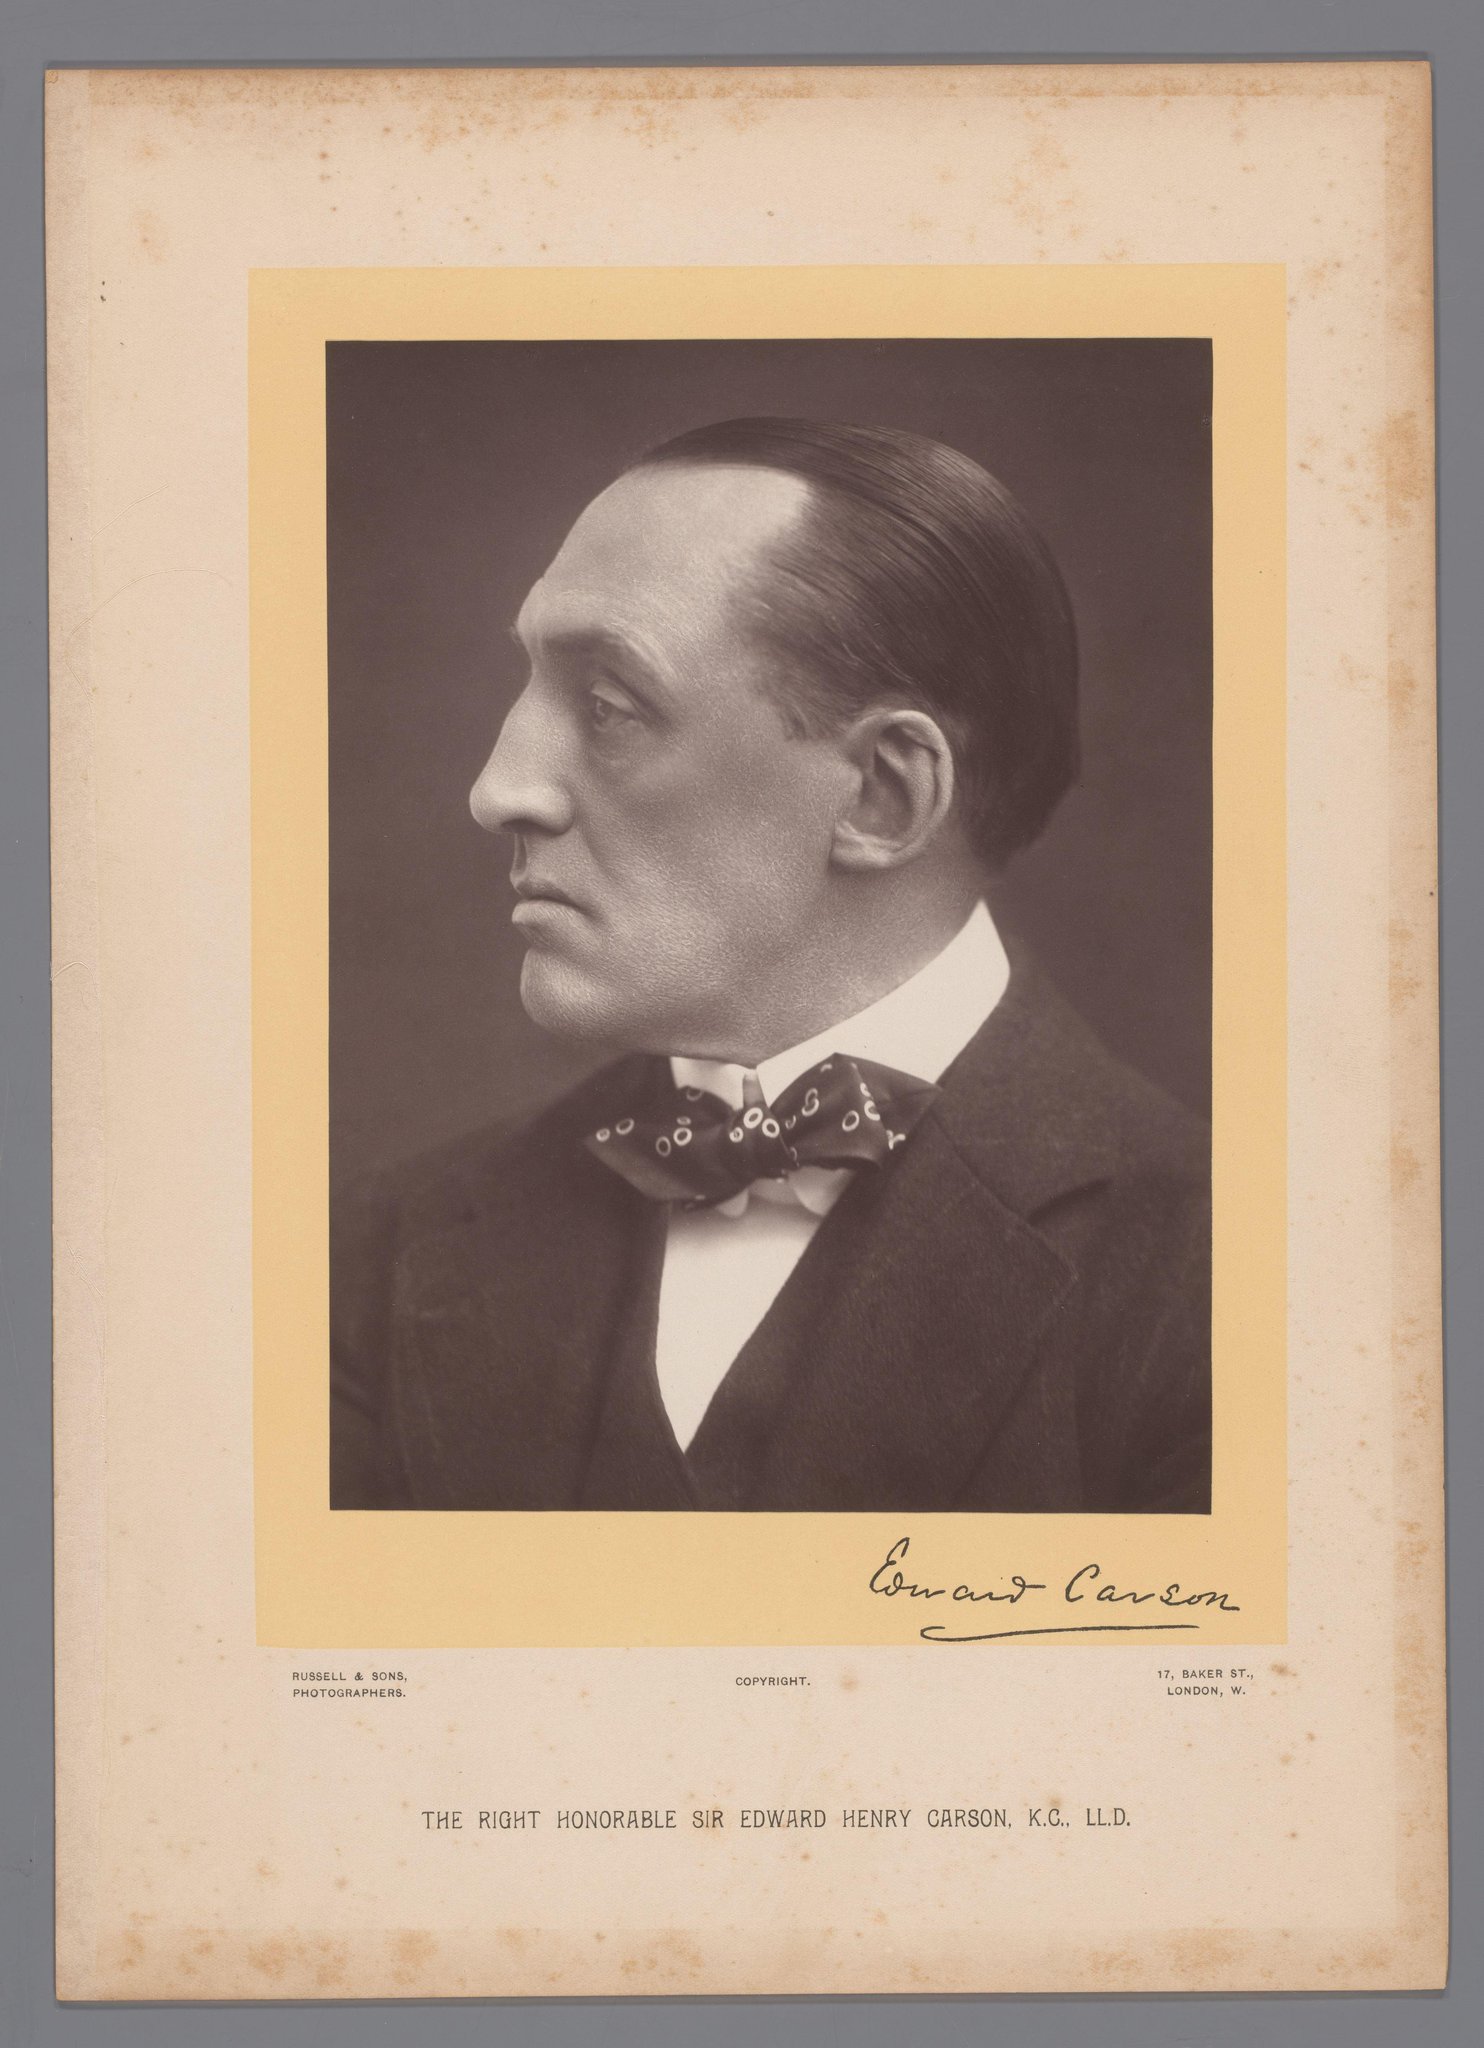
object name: photograph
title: Sir Edward Henry Carson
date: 1890-1910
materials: cardboard, paper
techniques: carbon print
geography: london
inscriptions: caption: ‘The Right Honorable Sir Edward Henry Carson, K.C., LL.D.’, caption: ‘Russell & Sons//Photographers//Copyright.//17, Baker St.//London W.’, caption: ‘Edward Carson’